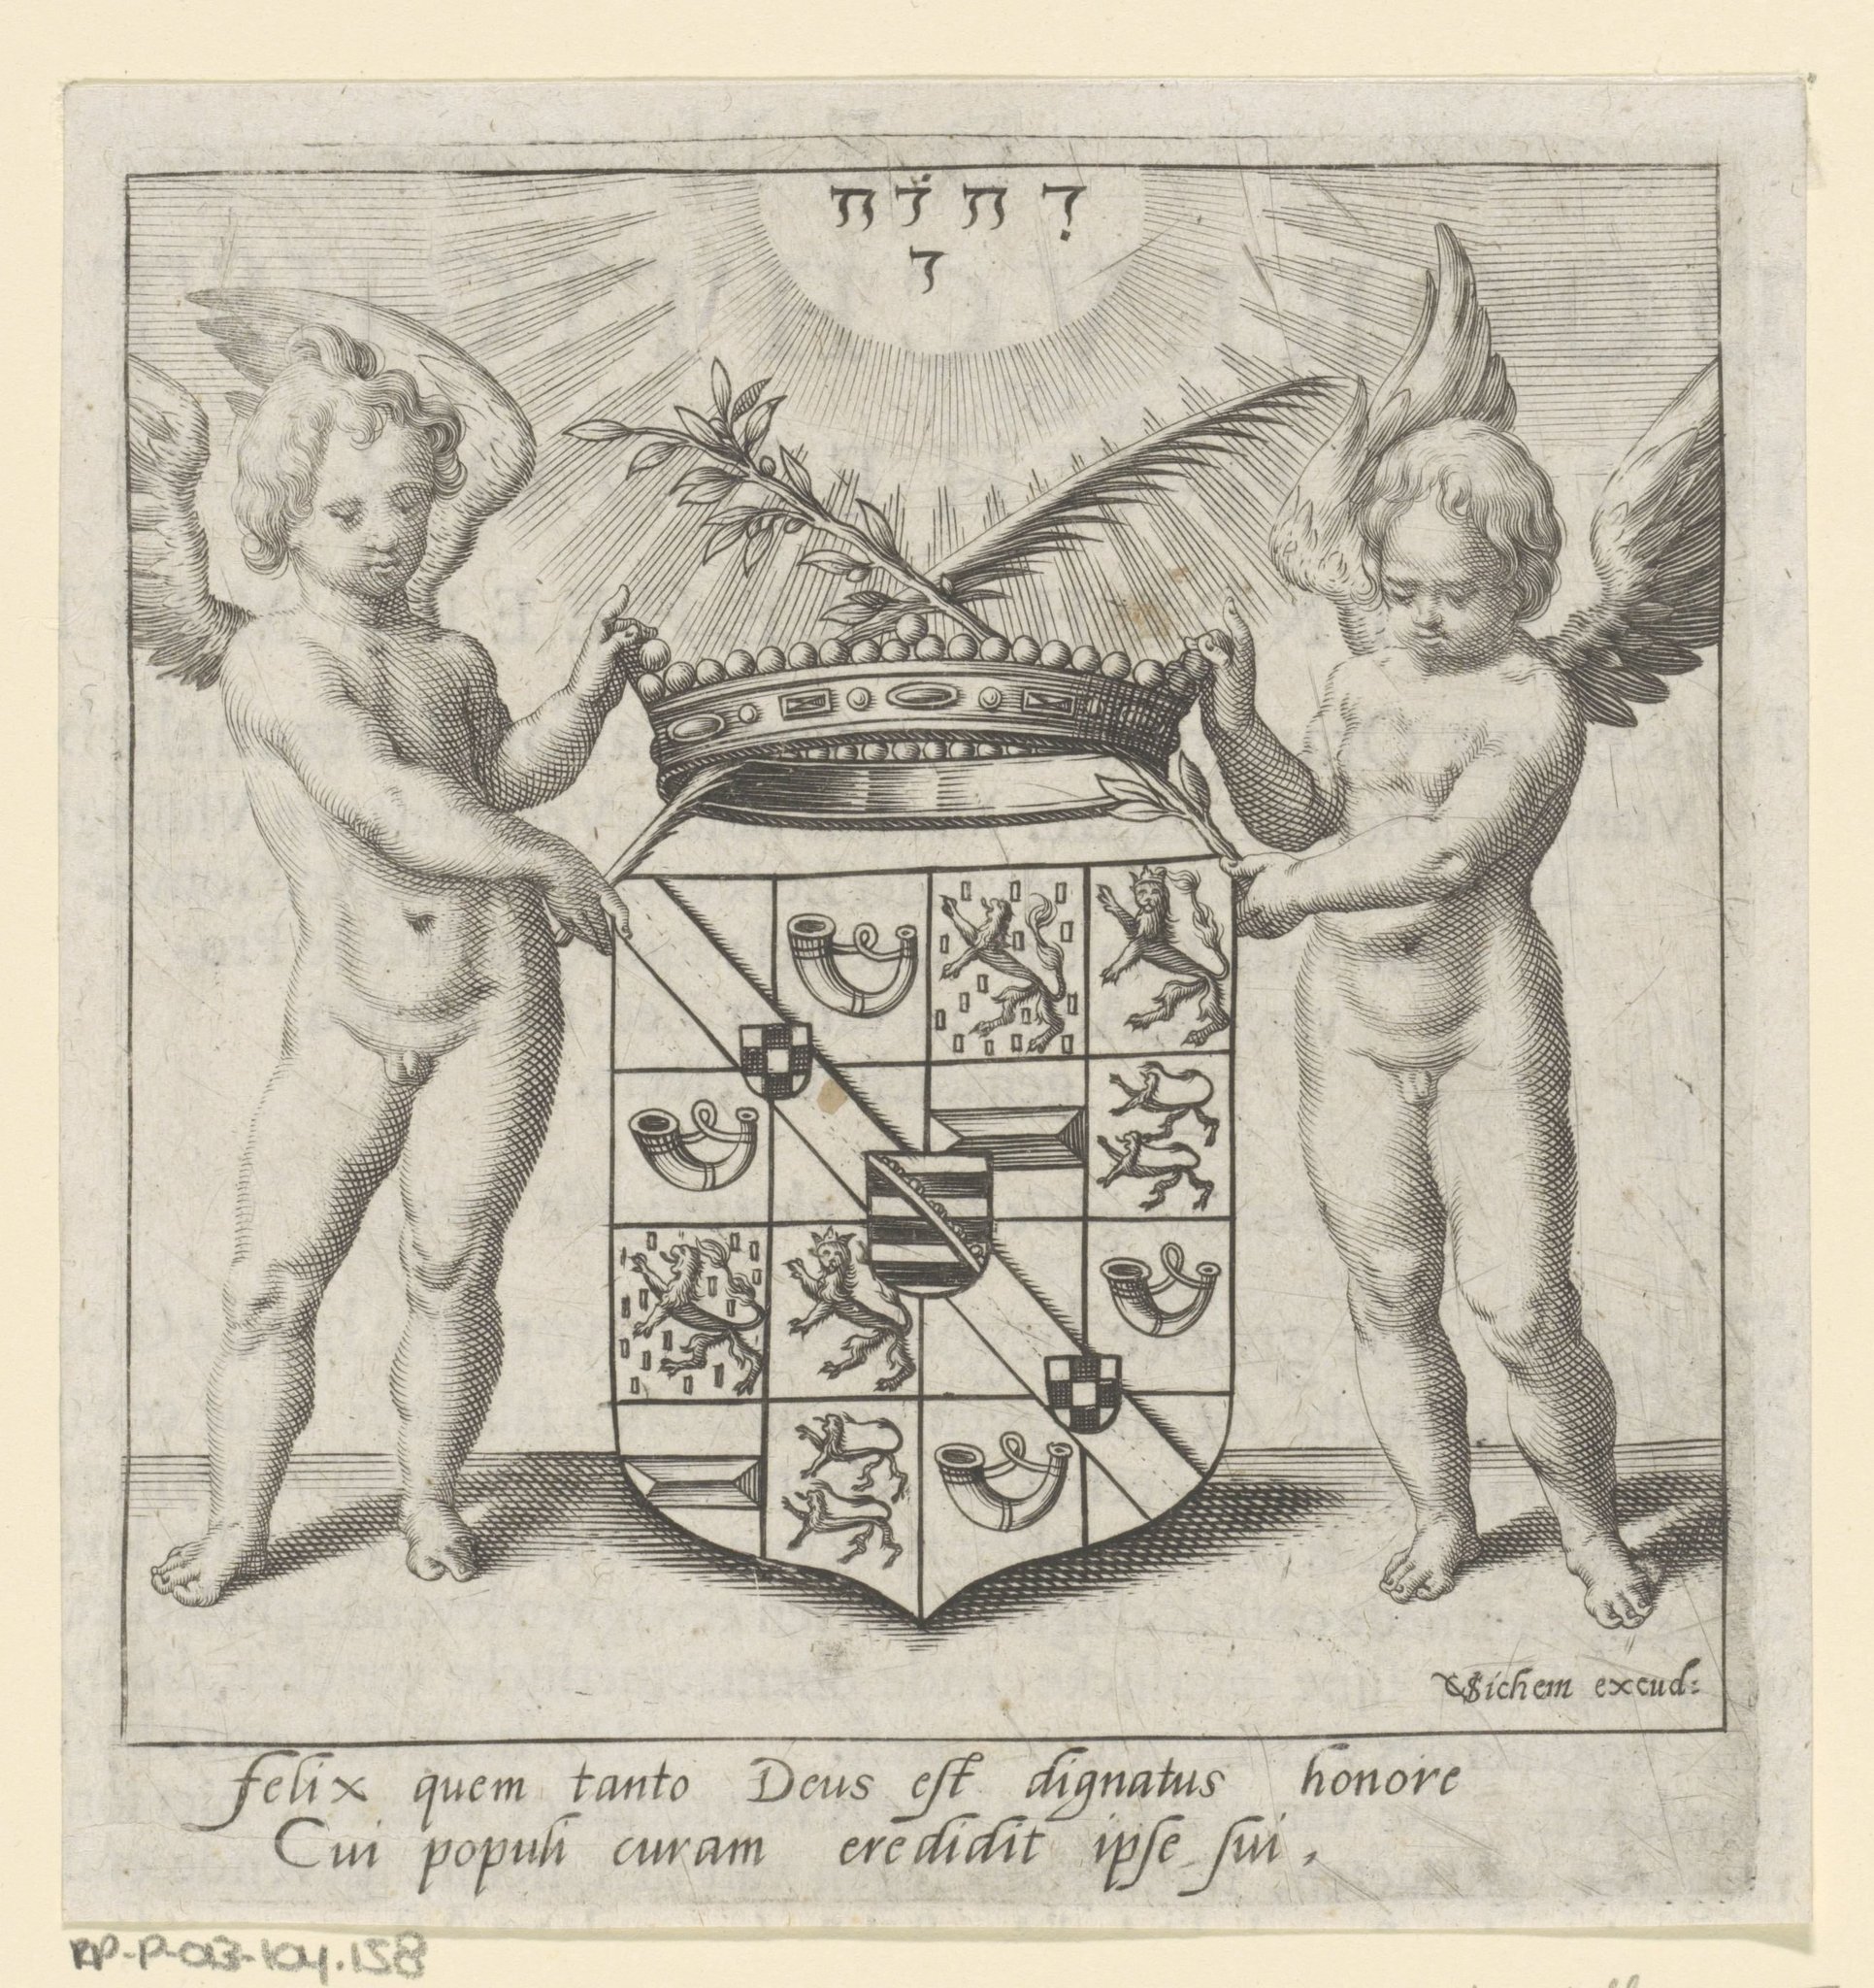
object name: print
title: Wapen van Maurits, prins van Oranje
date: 1555-1624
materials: paper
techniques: engraving, etching, letterpress printing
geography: low countries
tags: maurice (prince of orange)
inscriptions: collector's mark: Lugt 2228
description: Wapen van Maurits met een kroon, vastgehouden door twee putti. In de ondermarge twee regels Latijnse tekst.